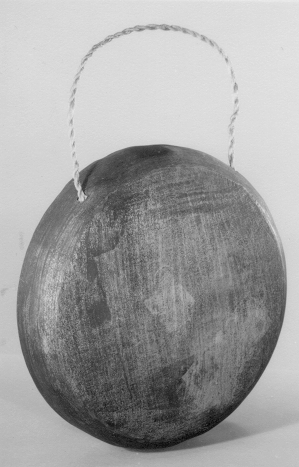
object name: lo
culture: chinese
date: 1801-1900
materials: bronze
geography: china